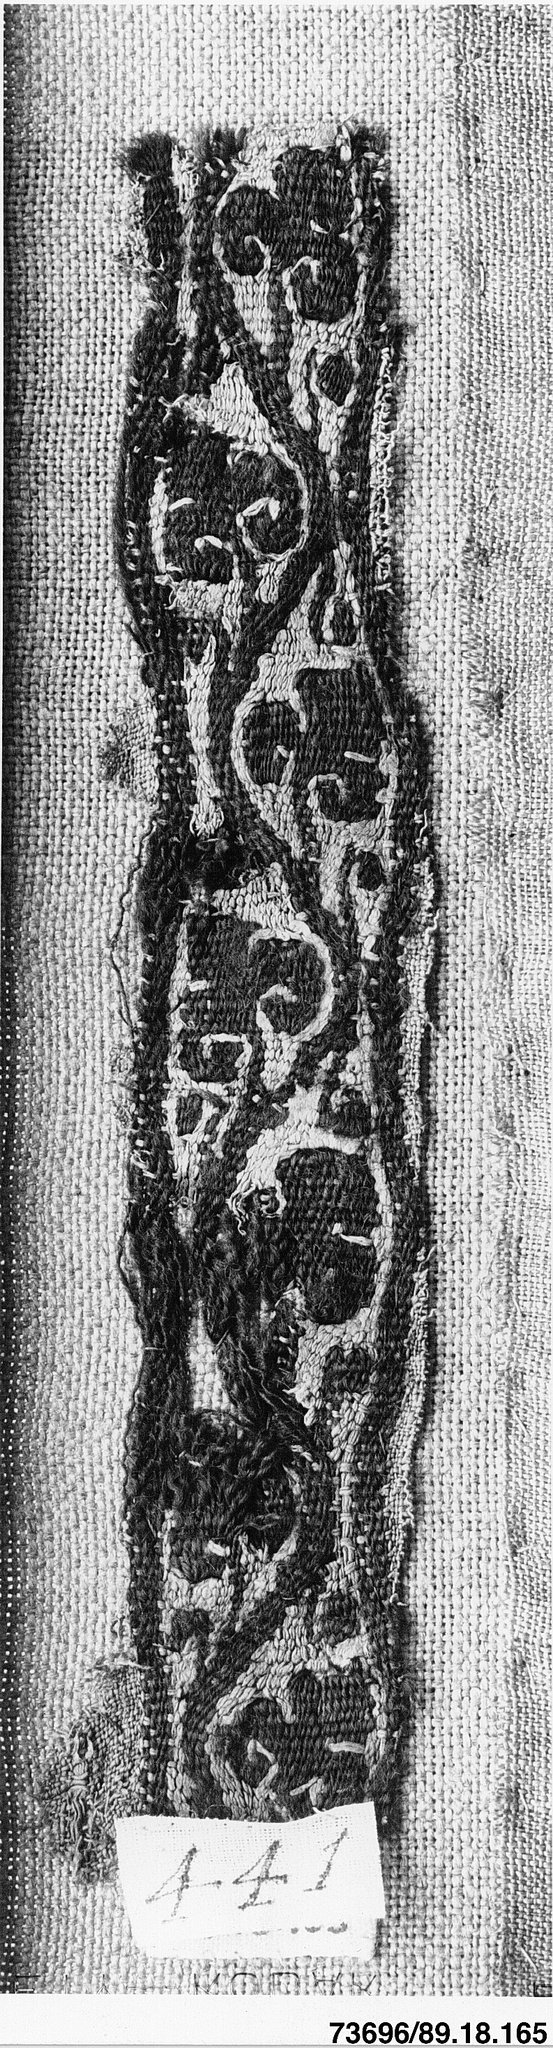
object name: textile fragment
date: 201-400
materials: linen, wool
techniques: weave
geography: egypt